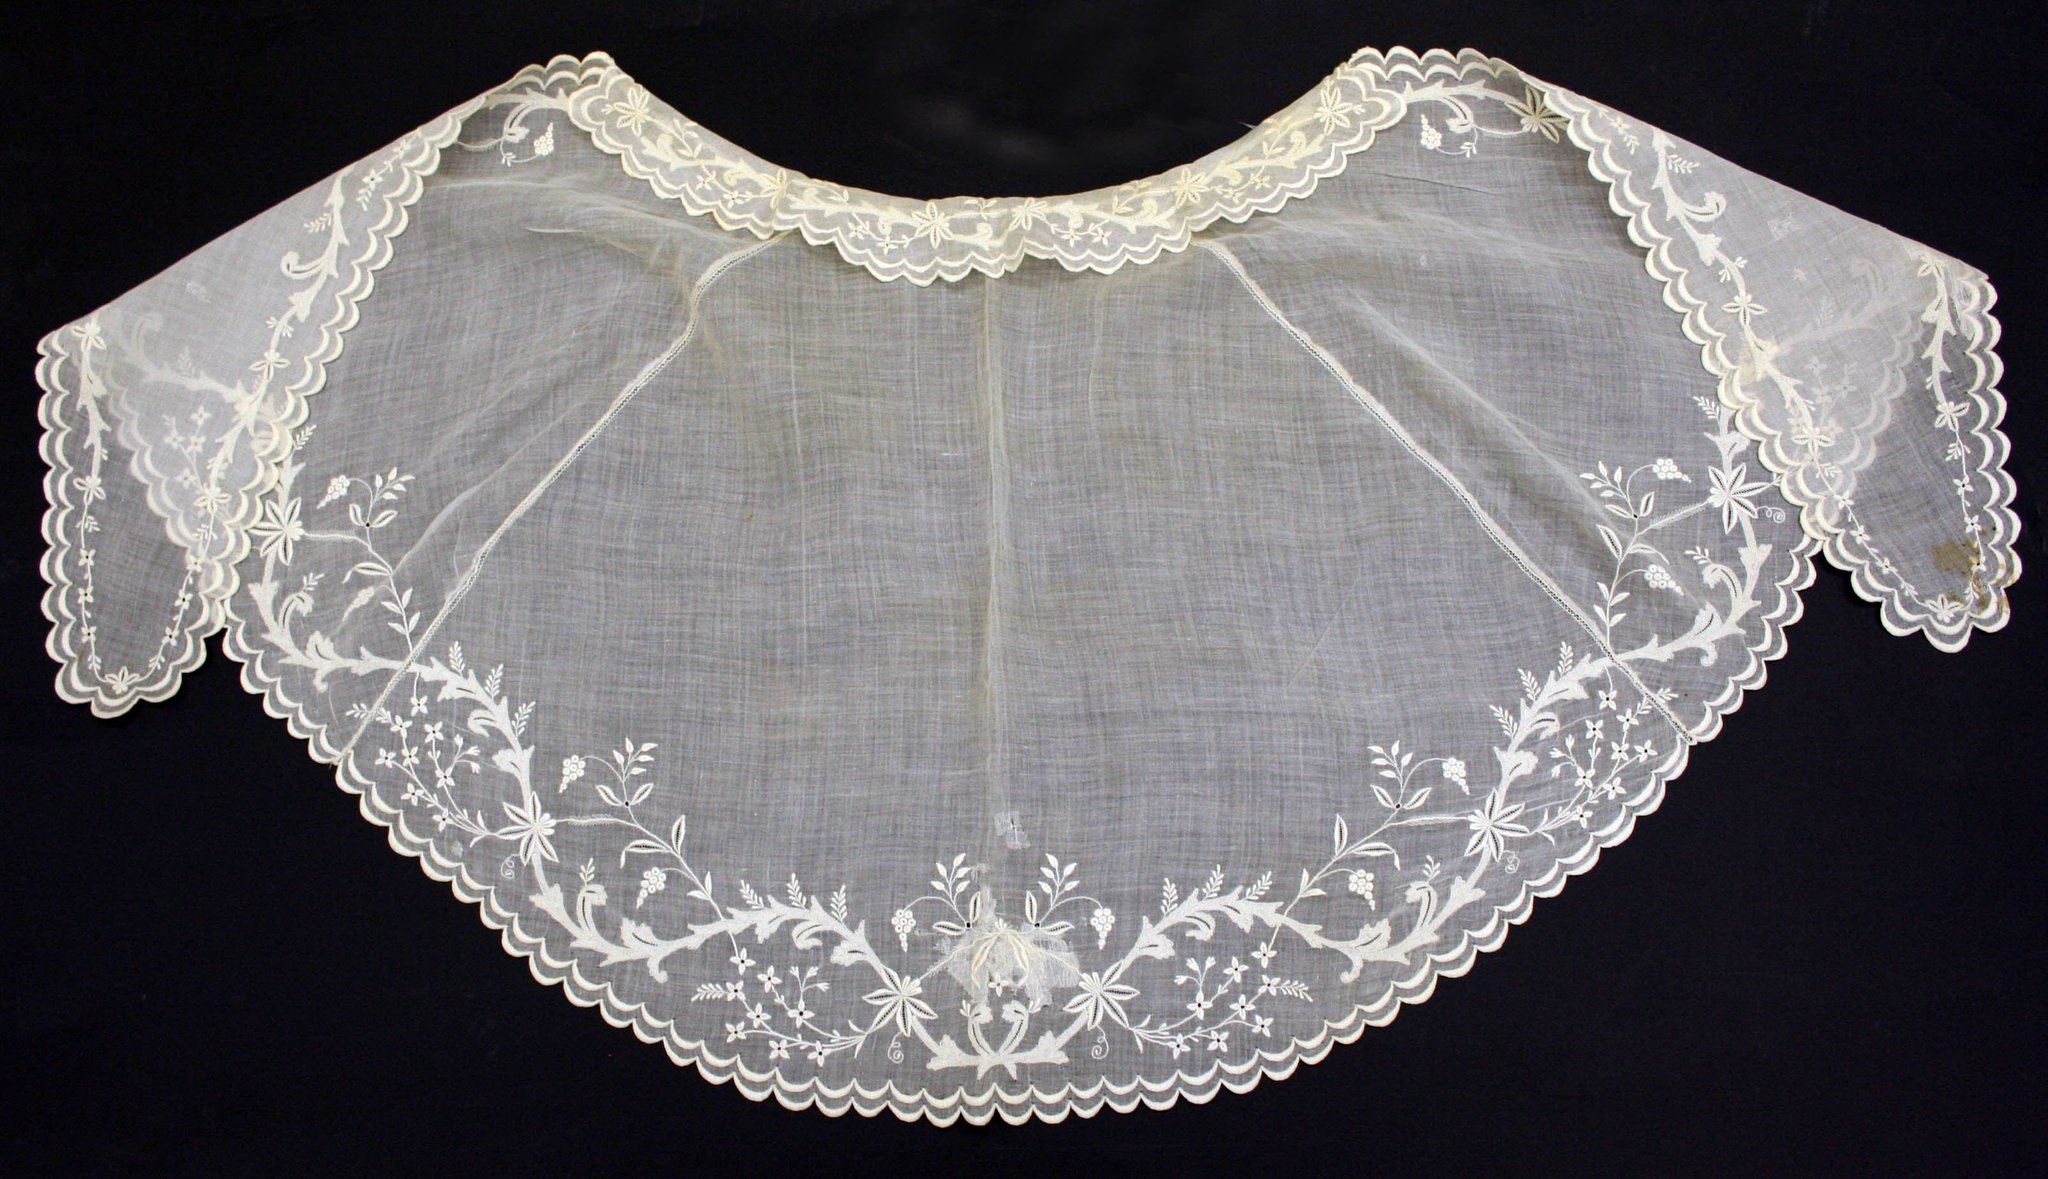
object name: fichu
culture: american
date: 1835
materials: cotton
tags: flowers